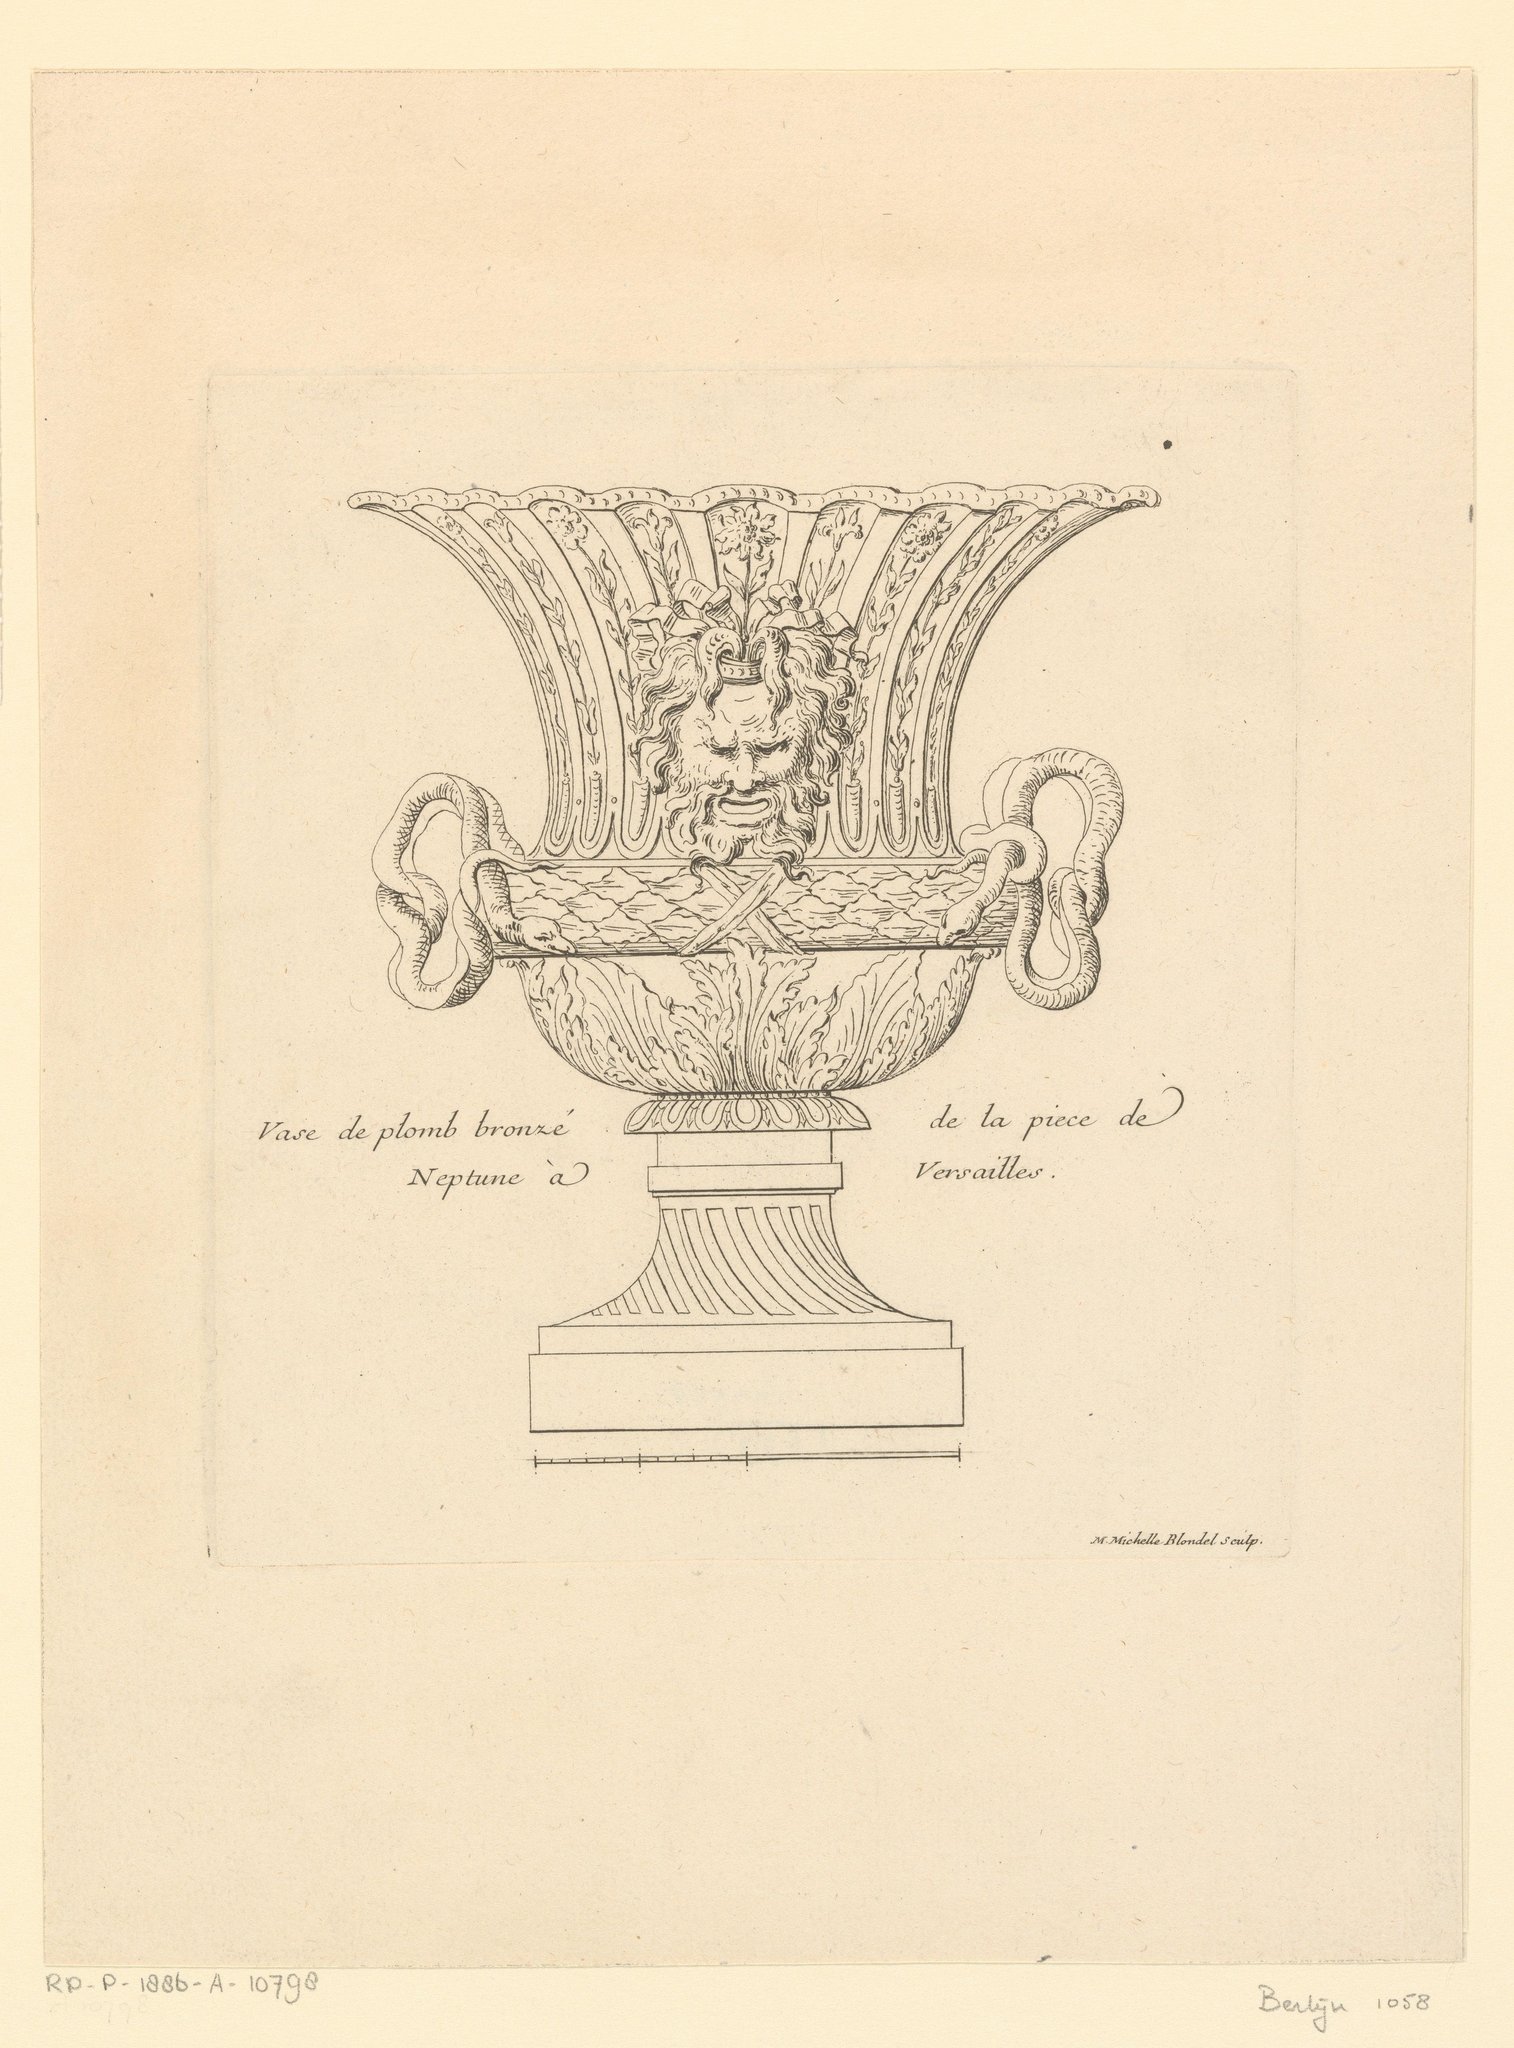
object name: ornament print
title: Siervaas met masker en slangen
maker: marie michelle blondel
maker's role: print maker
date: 1723-1774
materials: paper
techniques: etching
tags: snakes, mask, mascaron ~ ornament, garden vase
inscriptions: collector's mark: Lugt 2228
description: Een geornamenteerde siervaas met een mannelijk gezicht, bloem- en bladmotieven en twee slangen. Met tweeregelige Franse beschrijving.